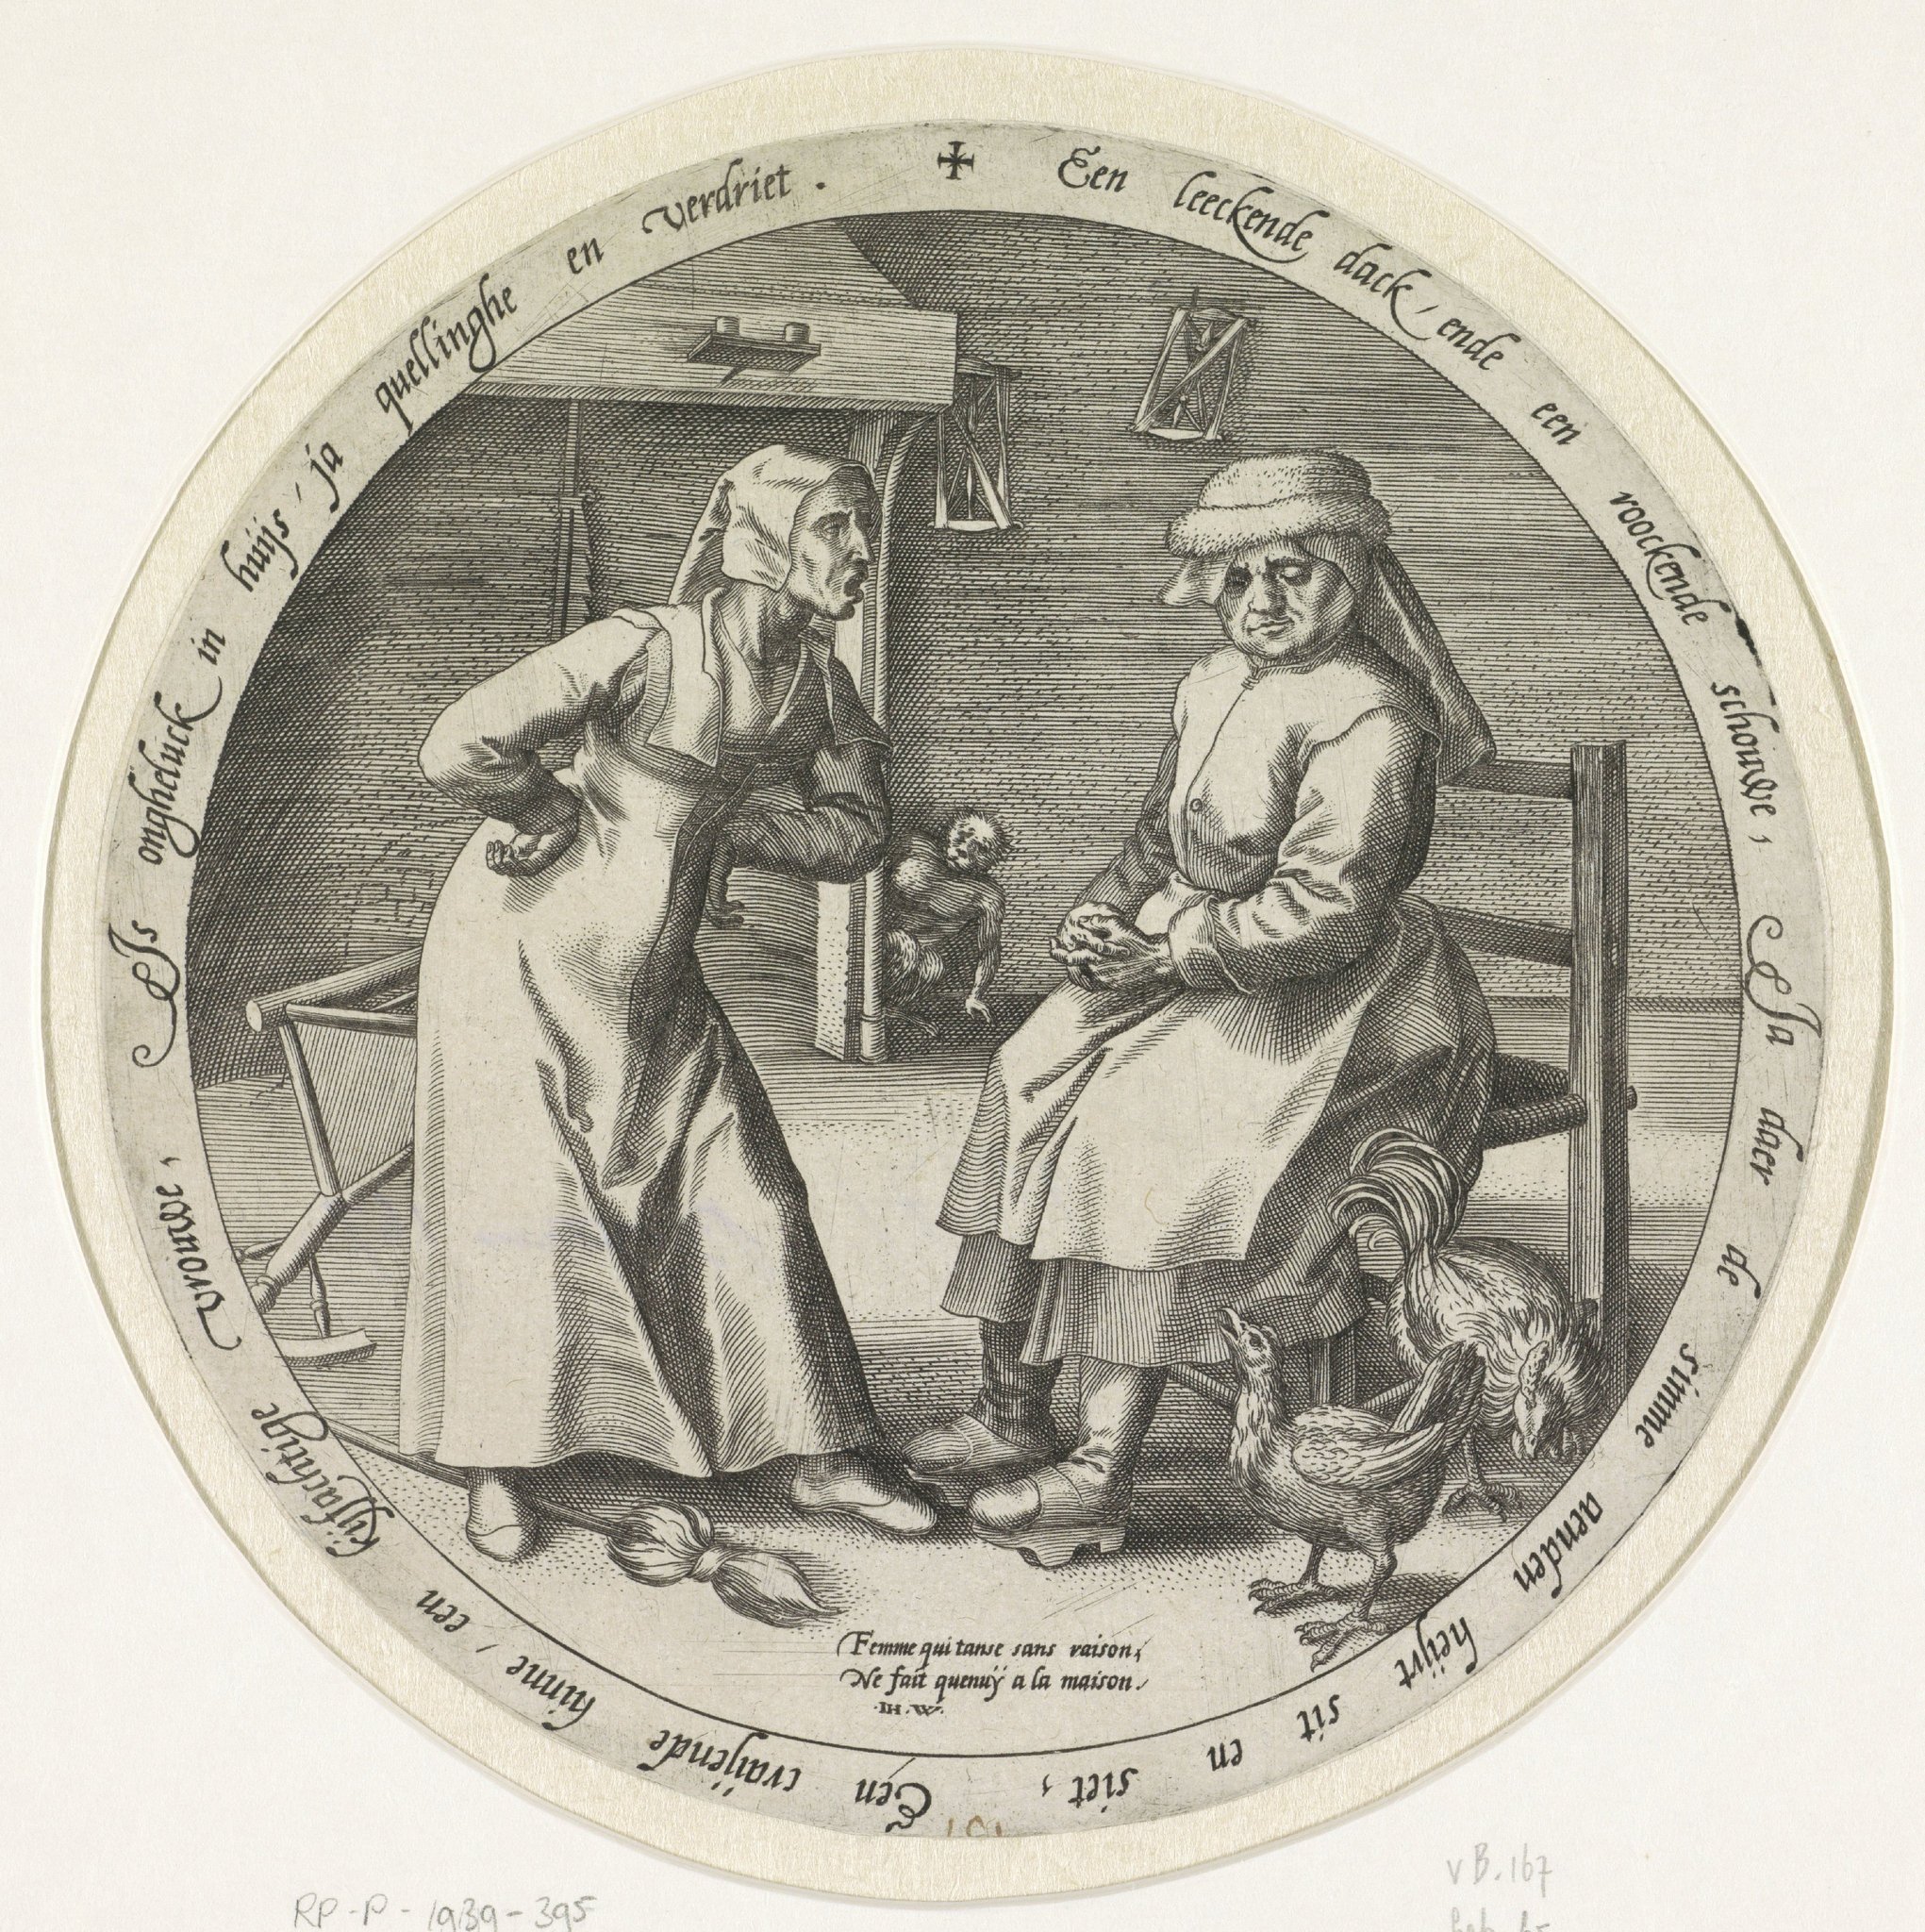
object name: print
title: De scheldende vrouw en de kakelende hen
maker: johannes wierix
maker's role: draughtsman, print maker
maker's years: 1549-1618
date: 1566-1570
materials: paper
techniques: engraving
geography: antwerp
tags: bad wife, man dressed as woman, travesty, monkeys, apes, battle for dominance in marriage ('who wears the breeches'), proverbs, sayings, etc., fowl (cock, hen, chicken, etc.)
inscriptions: circumscription: ‘Een leeckende dack, ende een roockende schouwe Ja daer de simme aenden heijrt sit en siet, Een craeijende hinne, een kijfachtige vrouwe, Is ongeluck in hijs, ja quellinghe en verdriet.’, collector's mark: Lugt 2228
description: Interieur met een vrouw die met de handen in de zij aan het schelden is. Haar man zit gekleed in vrouwenkleding op een stoel. Op de voorgrond een kakelende hen. Op de achtergrond een aap bij de schouw. In het randschrift een toelichting in het Nederlands: een lekkend dak, een rokende schouw, een kakelende hen en een scheldende vrouw in huis betekenen ongeluk en verdriet.